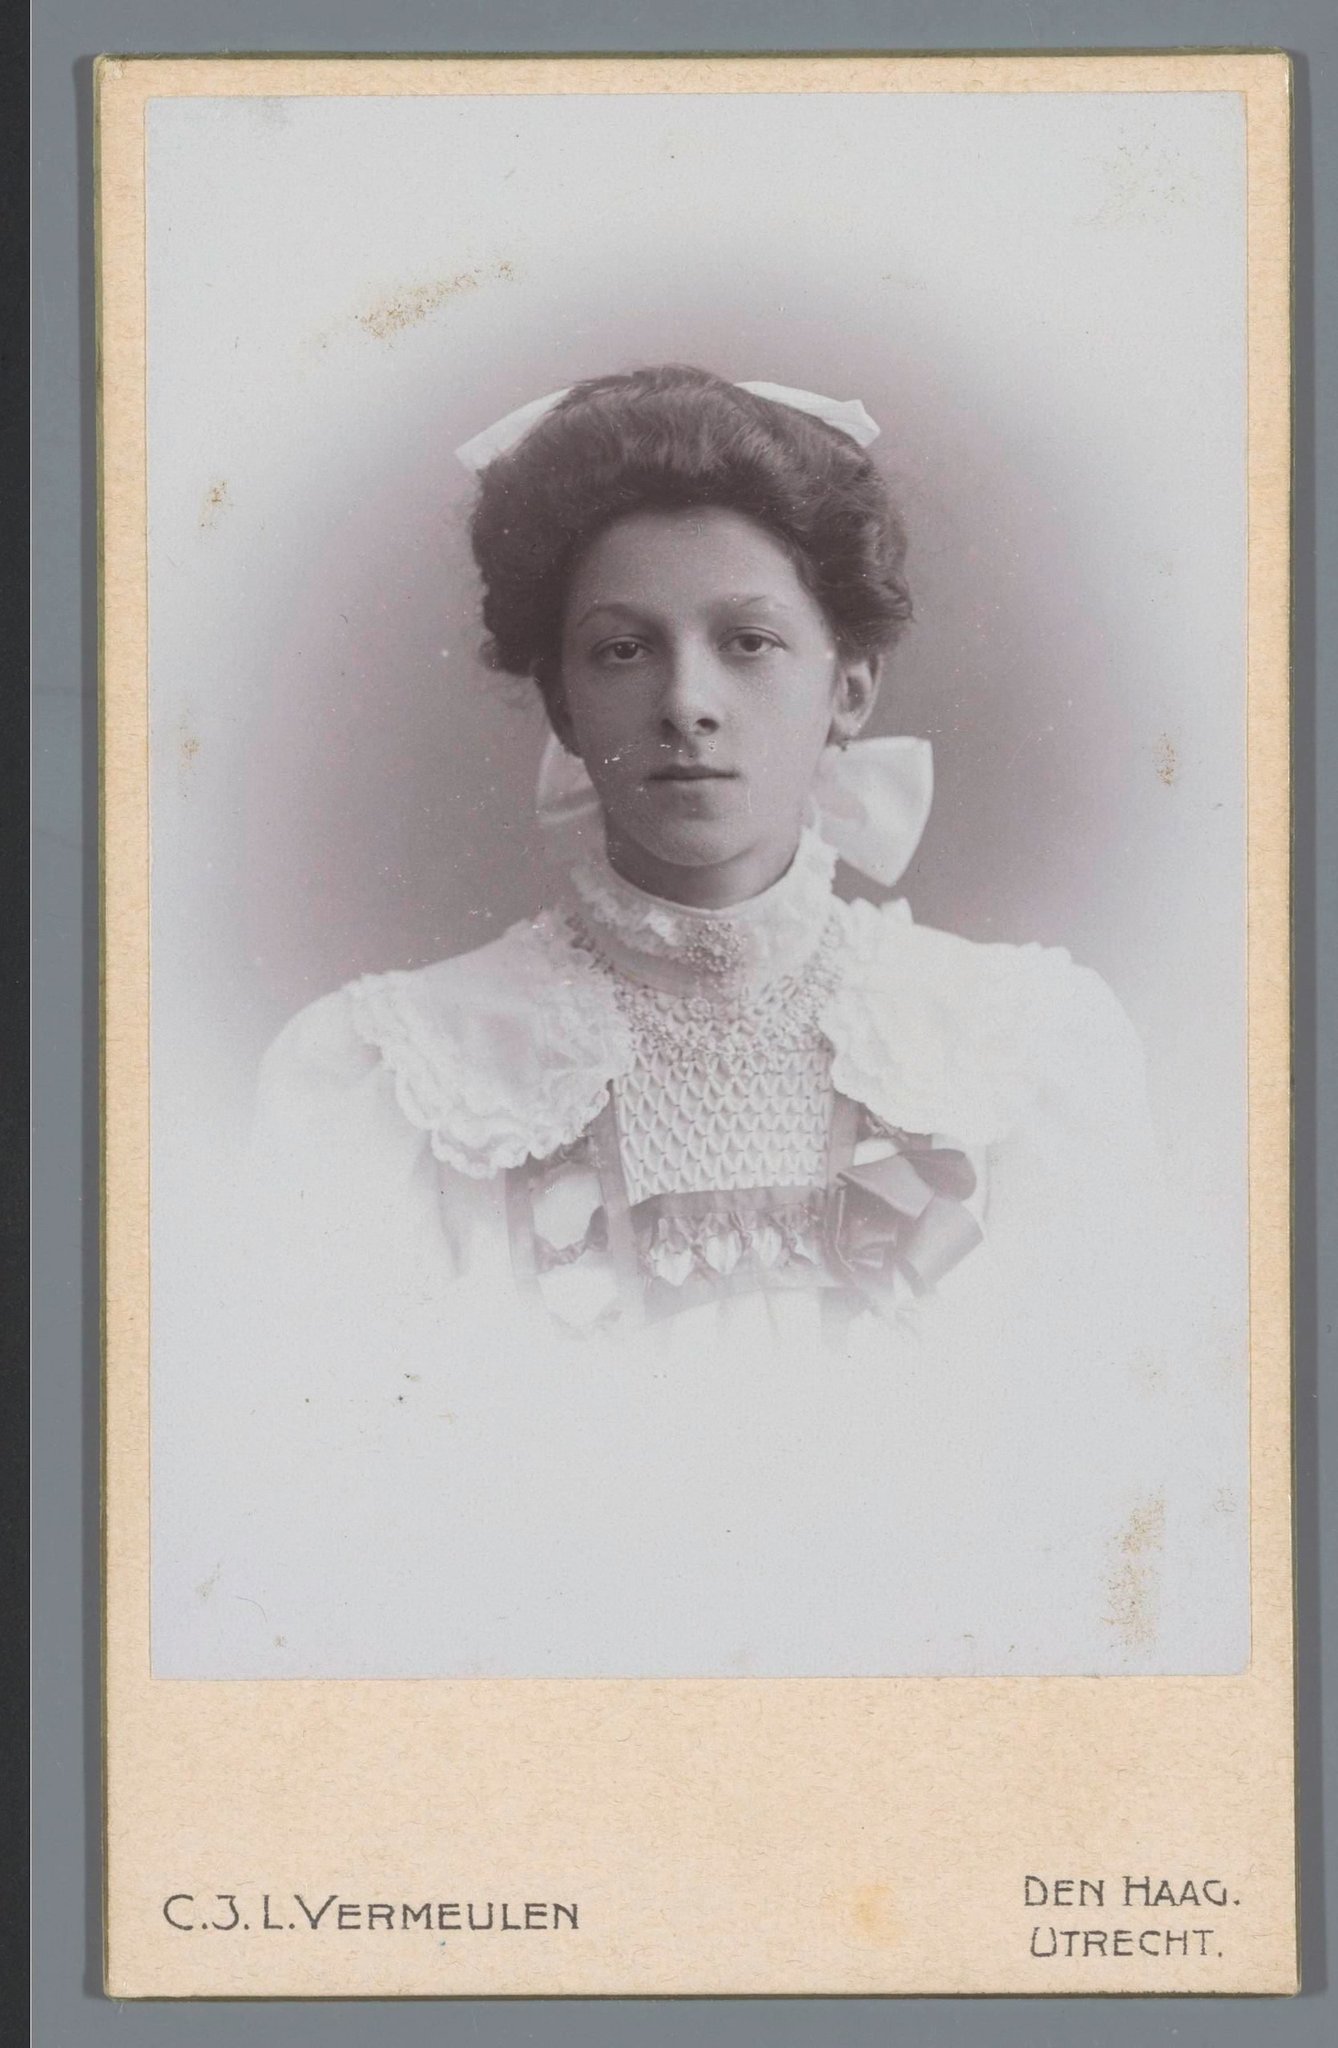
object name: photograph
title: Portret van een onbekende vrouw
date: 1900-1920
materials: cardboard, photographic support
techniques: collodion silver print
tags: historical persons - bb - woman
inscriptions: inscription: ‘C. J. L./ VERMEULEN/ ATELIER/ VOOR/ MODERNE FOTOGRAFIE/ DEN HAAG/ TOUSSAINTKADE 11/ TELEFOON 1673./ UTRECHT/ NIEUWEGRACHT 50/ TELEFOON 750.’